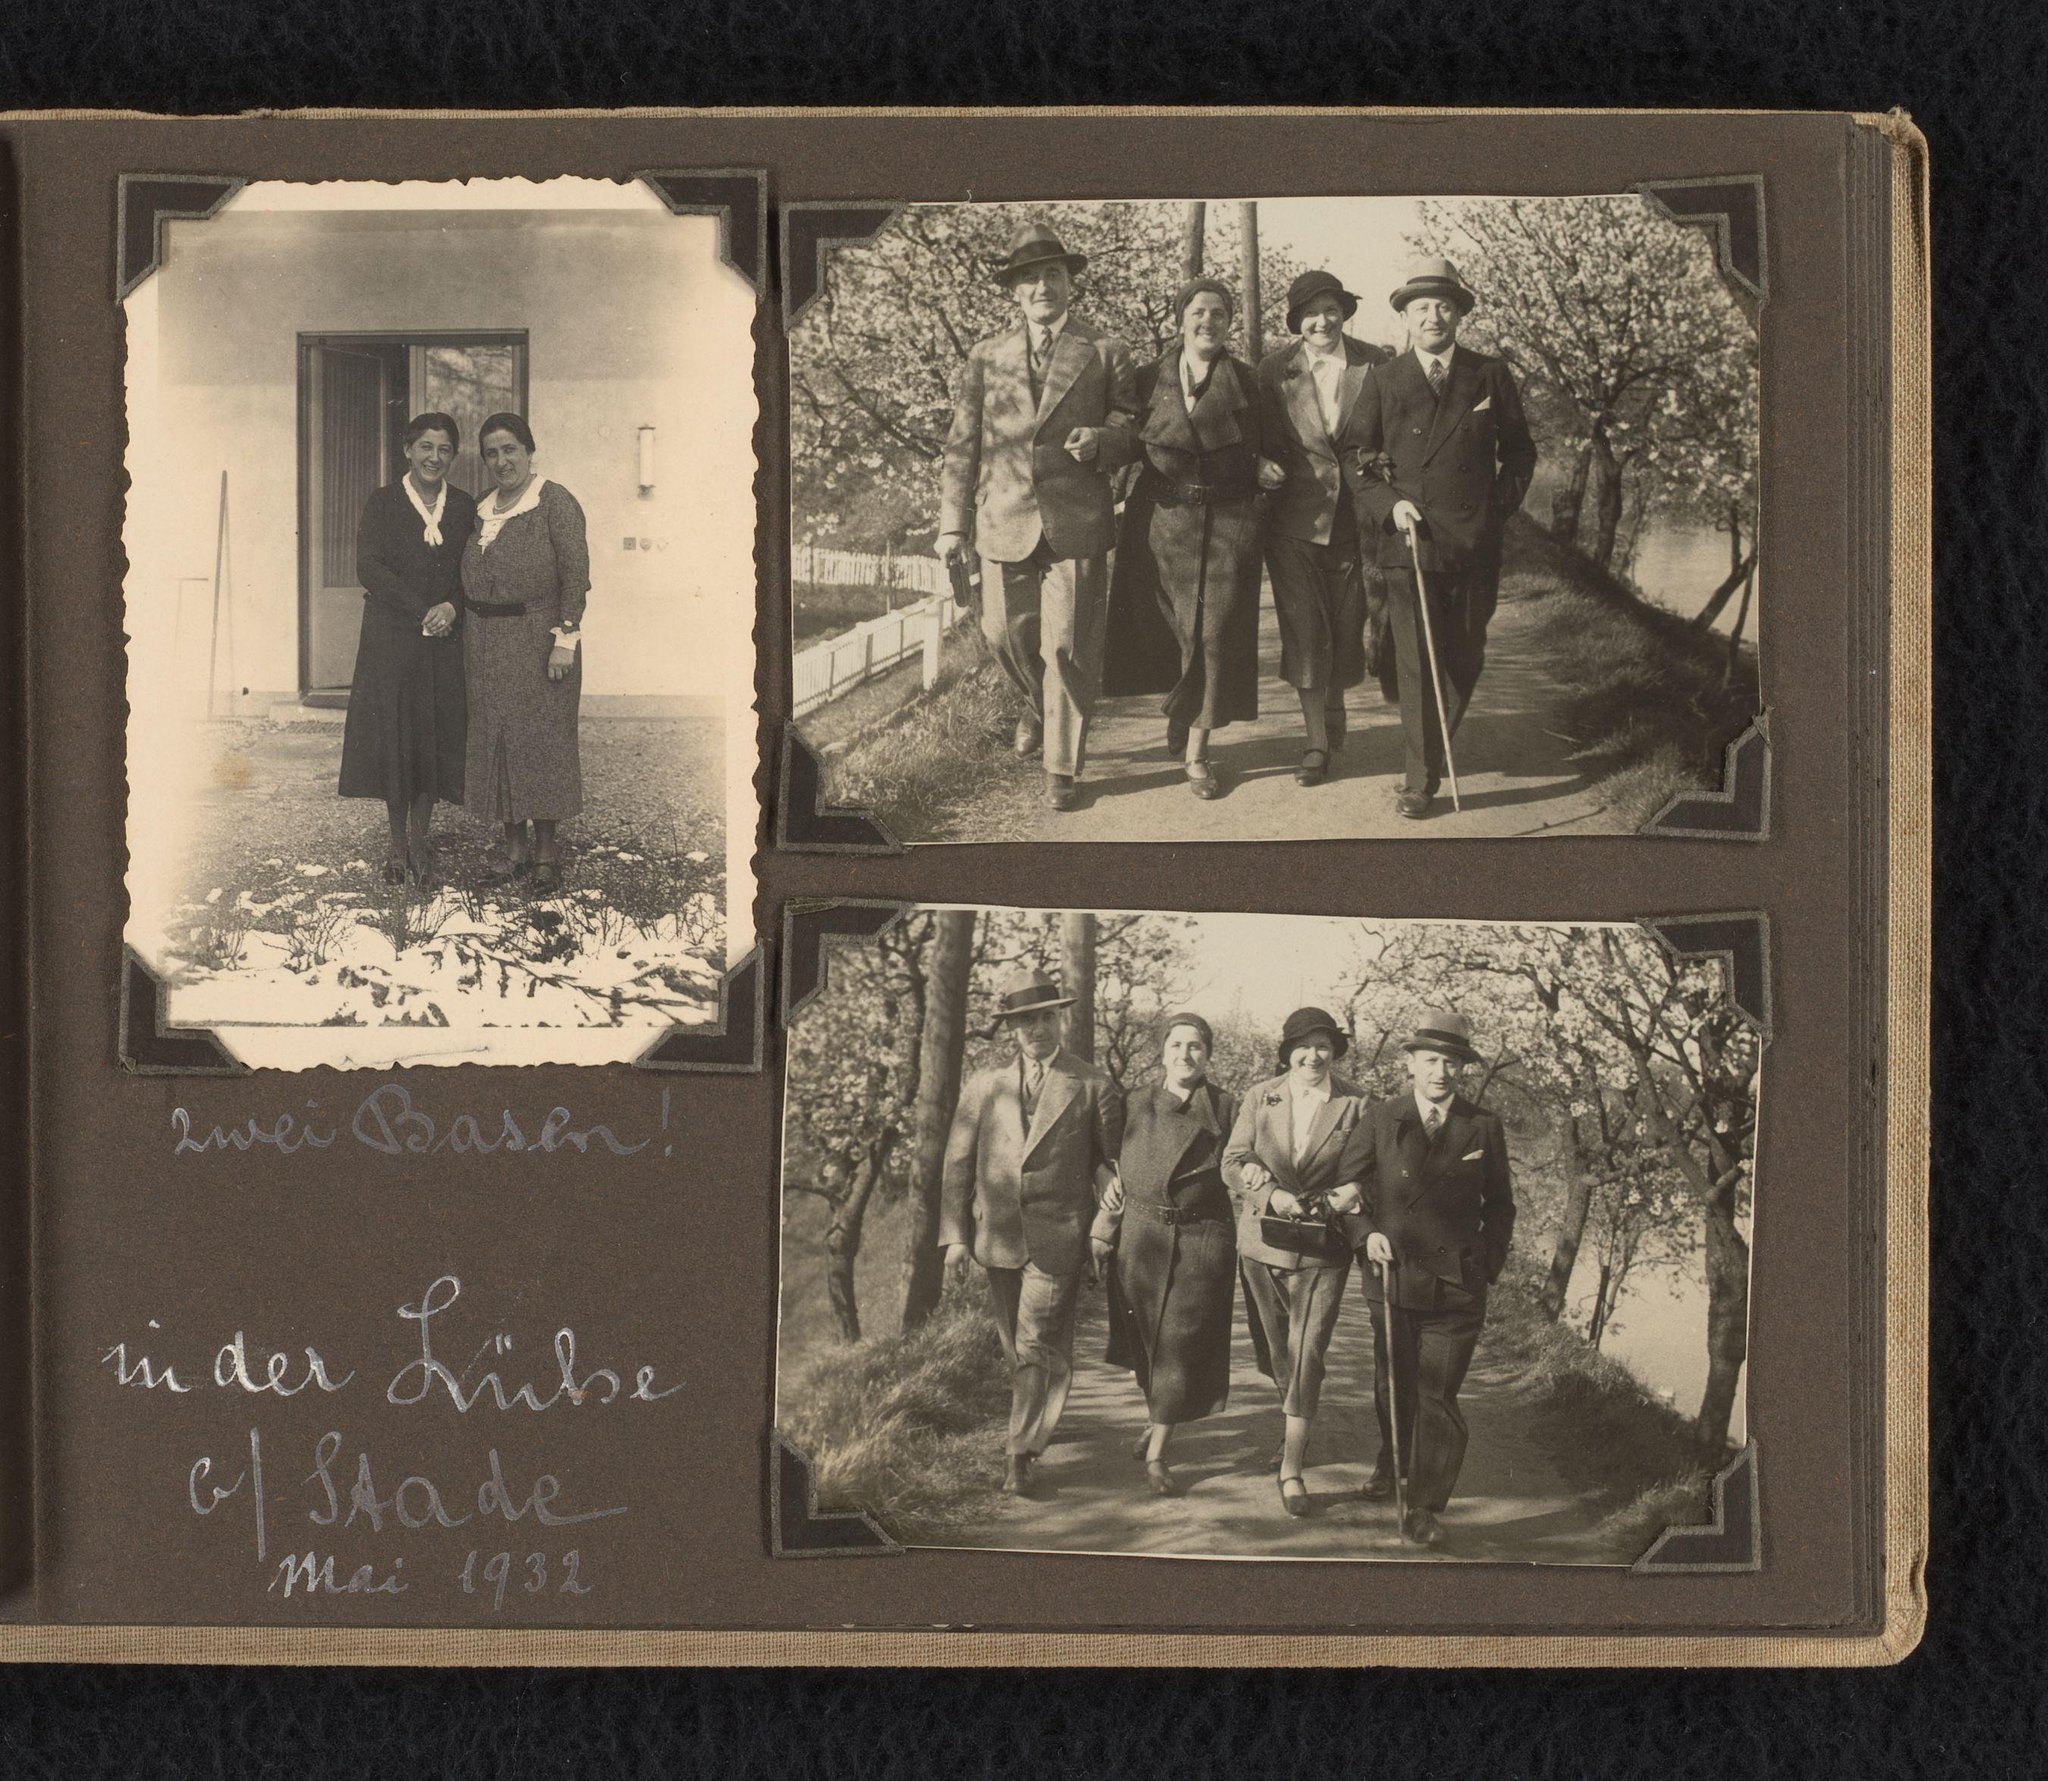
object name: photograph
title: Else Wachenheimer-Moos en haar broer Willy Moos met twee onbekende personen, mei 1932, Stade (Saksen)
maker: else wachenheimer-moos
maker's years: 1895-1944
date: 1905-1932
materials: cardboard, photographic support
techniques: gelatin silver print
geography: germany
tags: eugen wachenheimer, else wachenheimer-moos, willy moos, family life at home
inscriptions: inscription: ‘zwei Basen! in der Lühe a/ Stade mai 1932’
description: Blad bevat drie foto's. Alle foto's van Else Wachenheimer-Moos (in donkere kleding), Willy Moos (met hoed en wandelstok), een onbekende vrouw, een onbekende man. Uit het album, half formaat, crèmekleurig stofomslag met koordbinding met banenmotief.